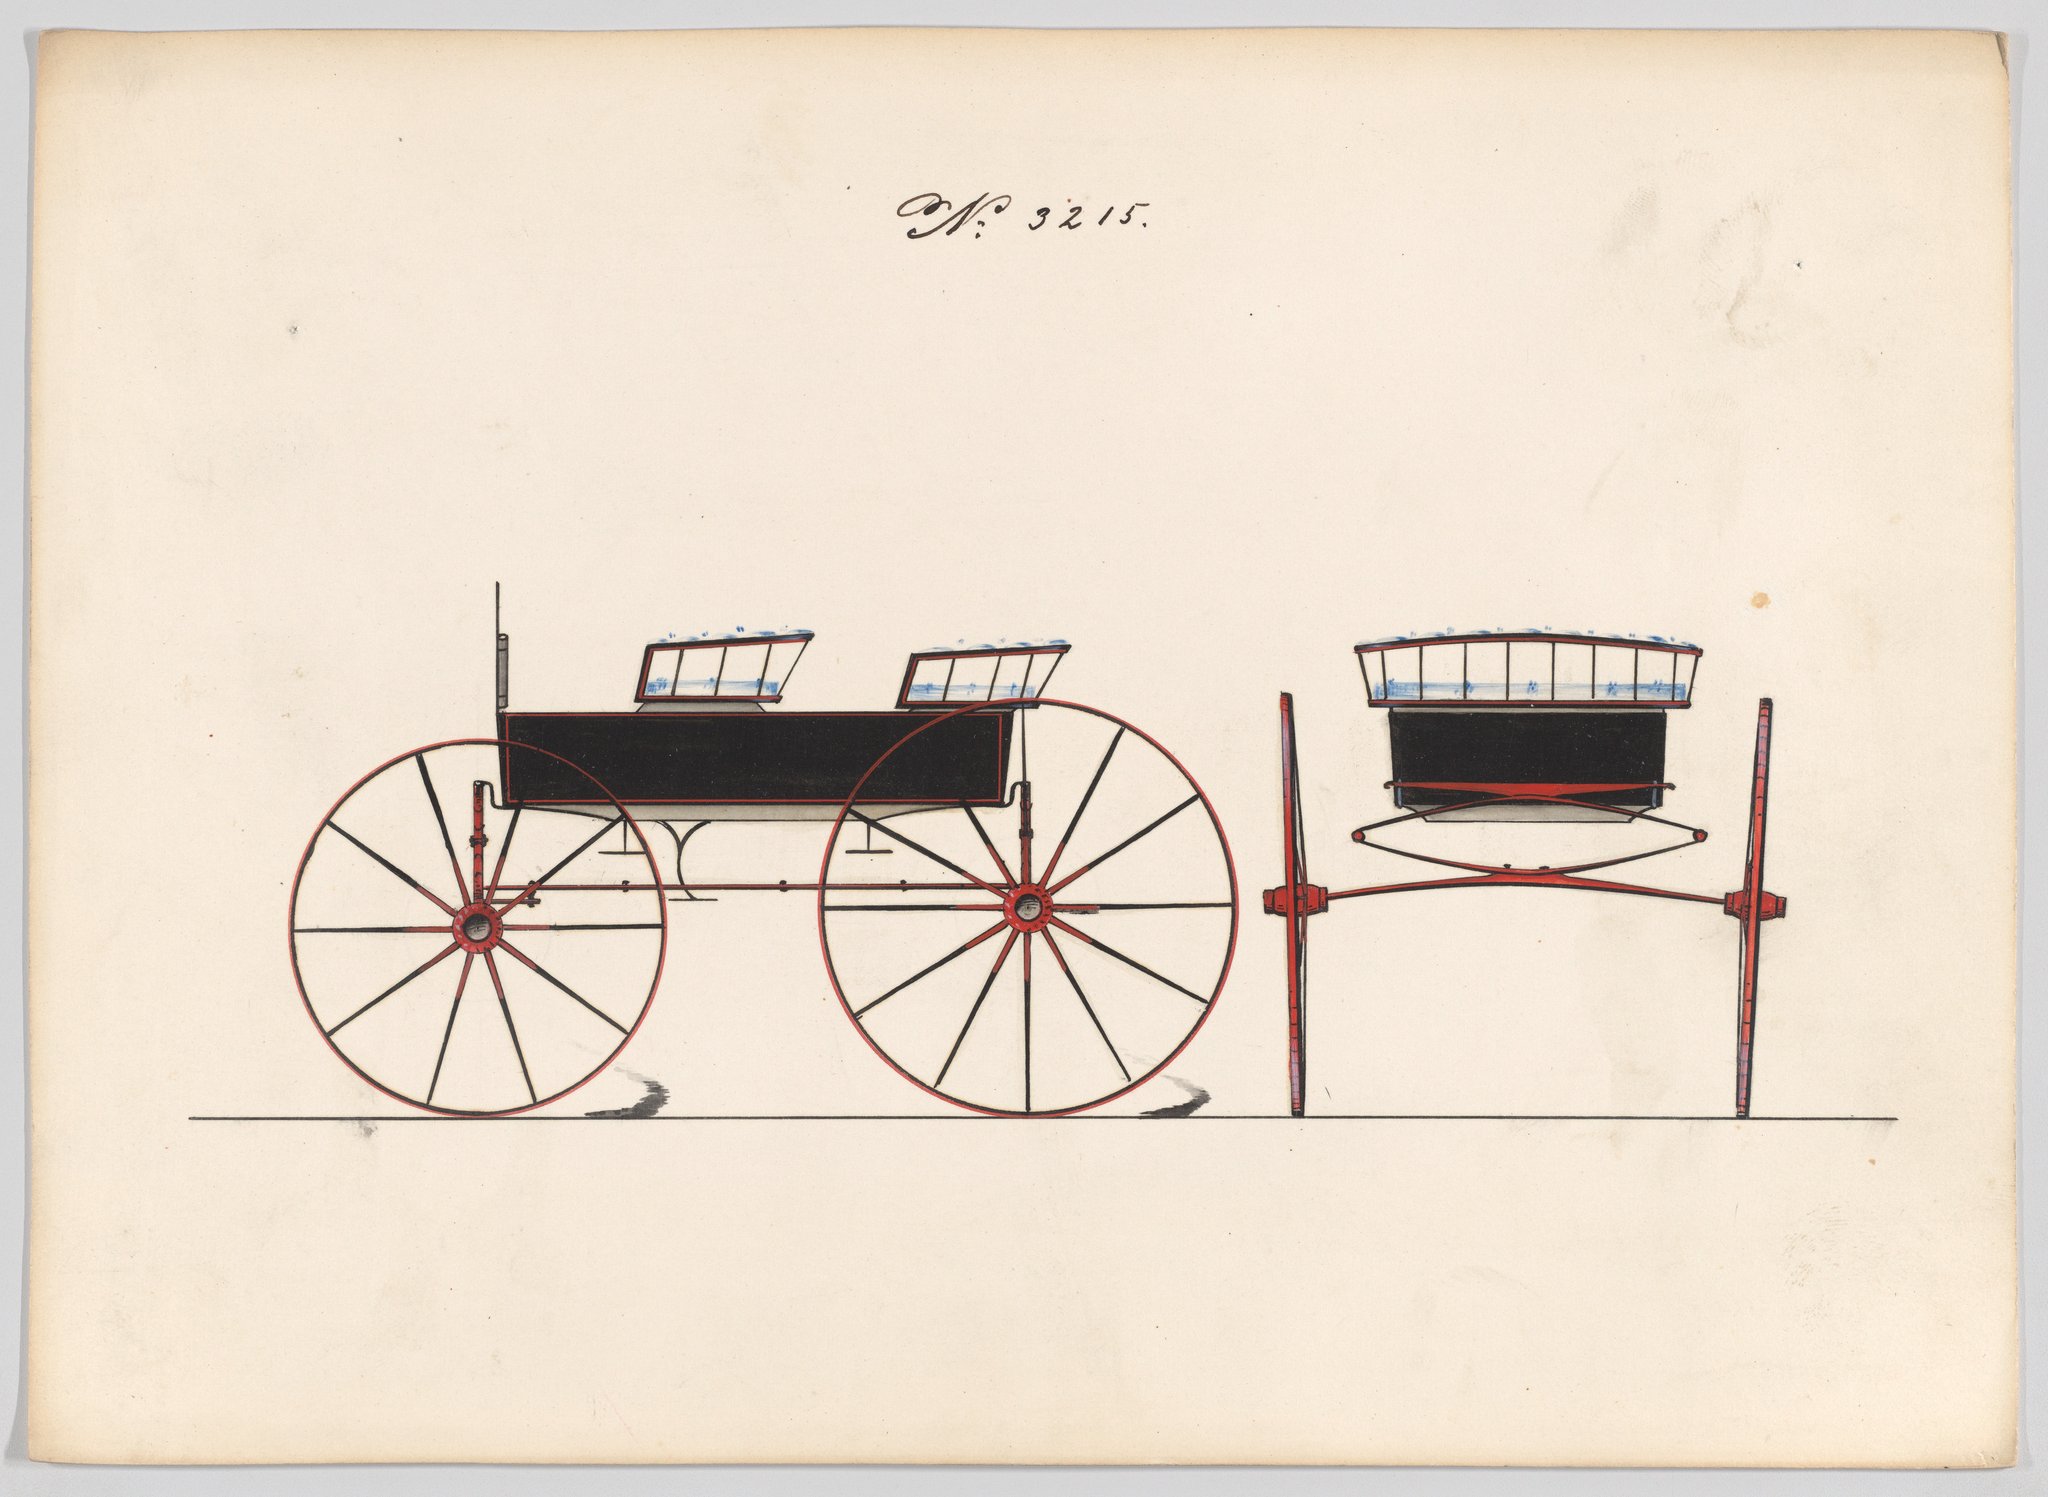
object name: drawing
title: Design for T-Cart, no. 3215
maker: brewster & co.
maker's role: manufacturer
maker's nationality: american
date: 1876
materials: gouache, gum arabic, ink, watercolor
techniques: pen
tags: carriages